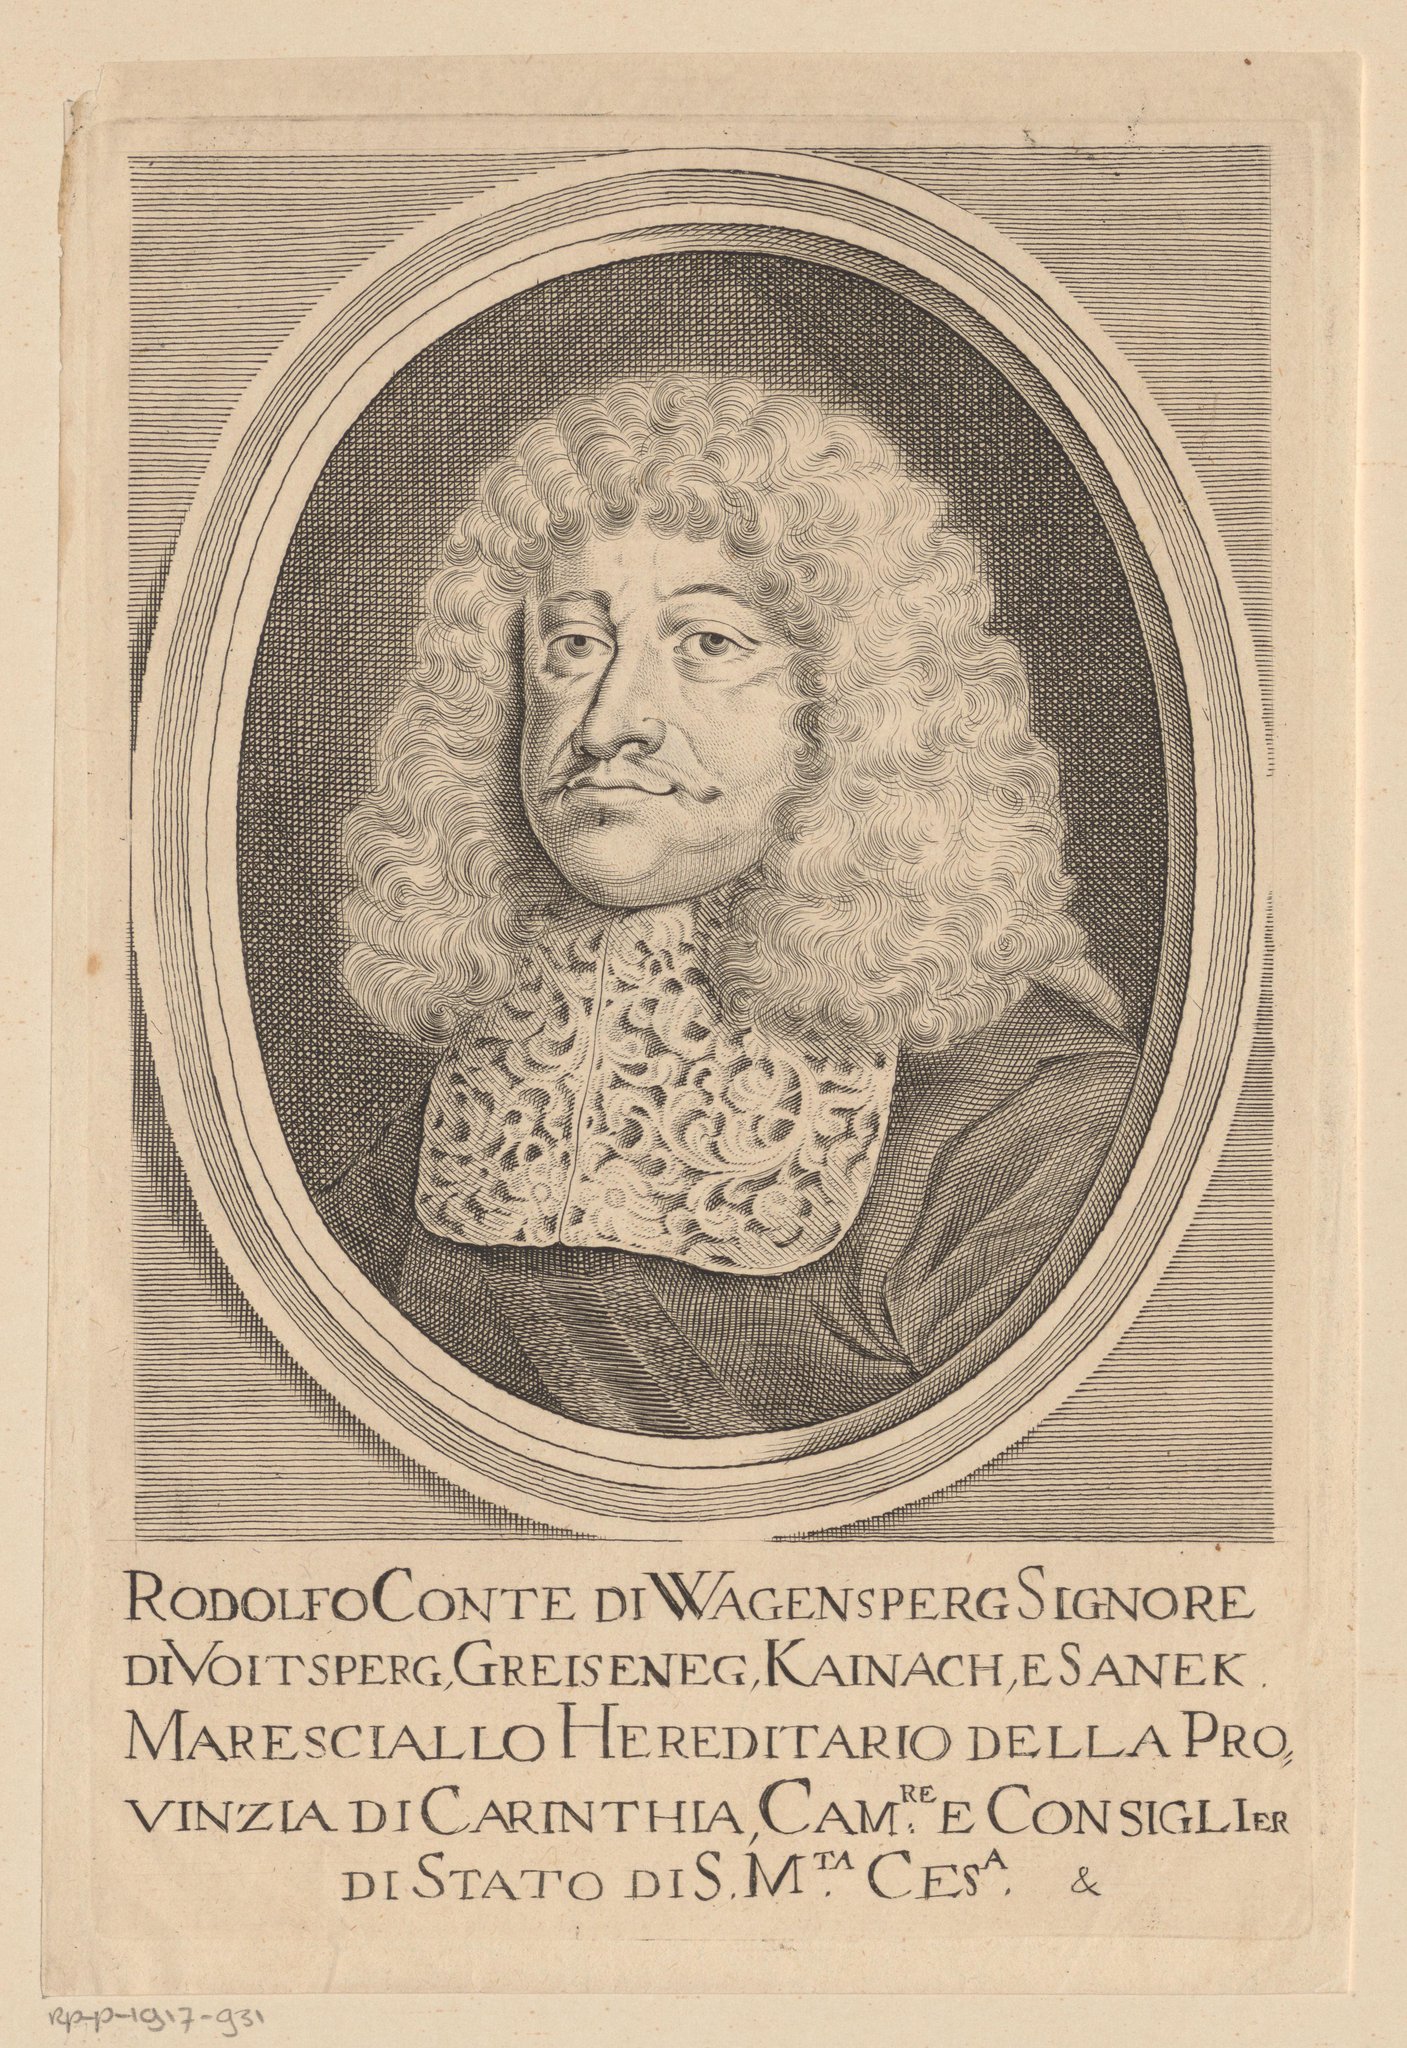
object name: print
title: Portret van Rudolf, graaf van Wagensperg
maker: cornelis meyssens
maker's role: print maker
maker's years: 1640-1673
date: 1674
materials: paper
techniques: engraving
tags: historical persons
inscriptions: collector's mark: Lugt 2228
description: Prent waarschijnlijk uit: Gualdo Priorato, Galeazzo. Historia di Leopoldo Cesare (...). Wenen: Johann Baptist Hacque, 1674, dl. 3.